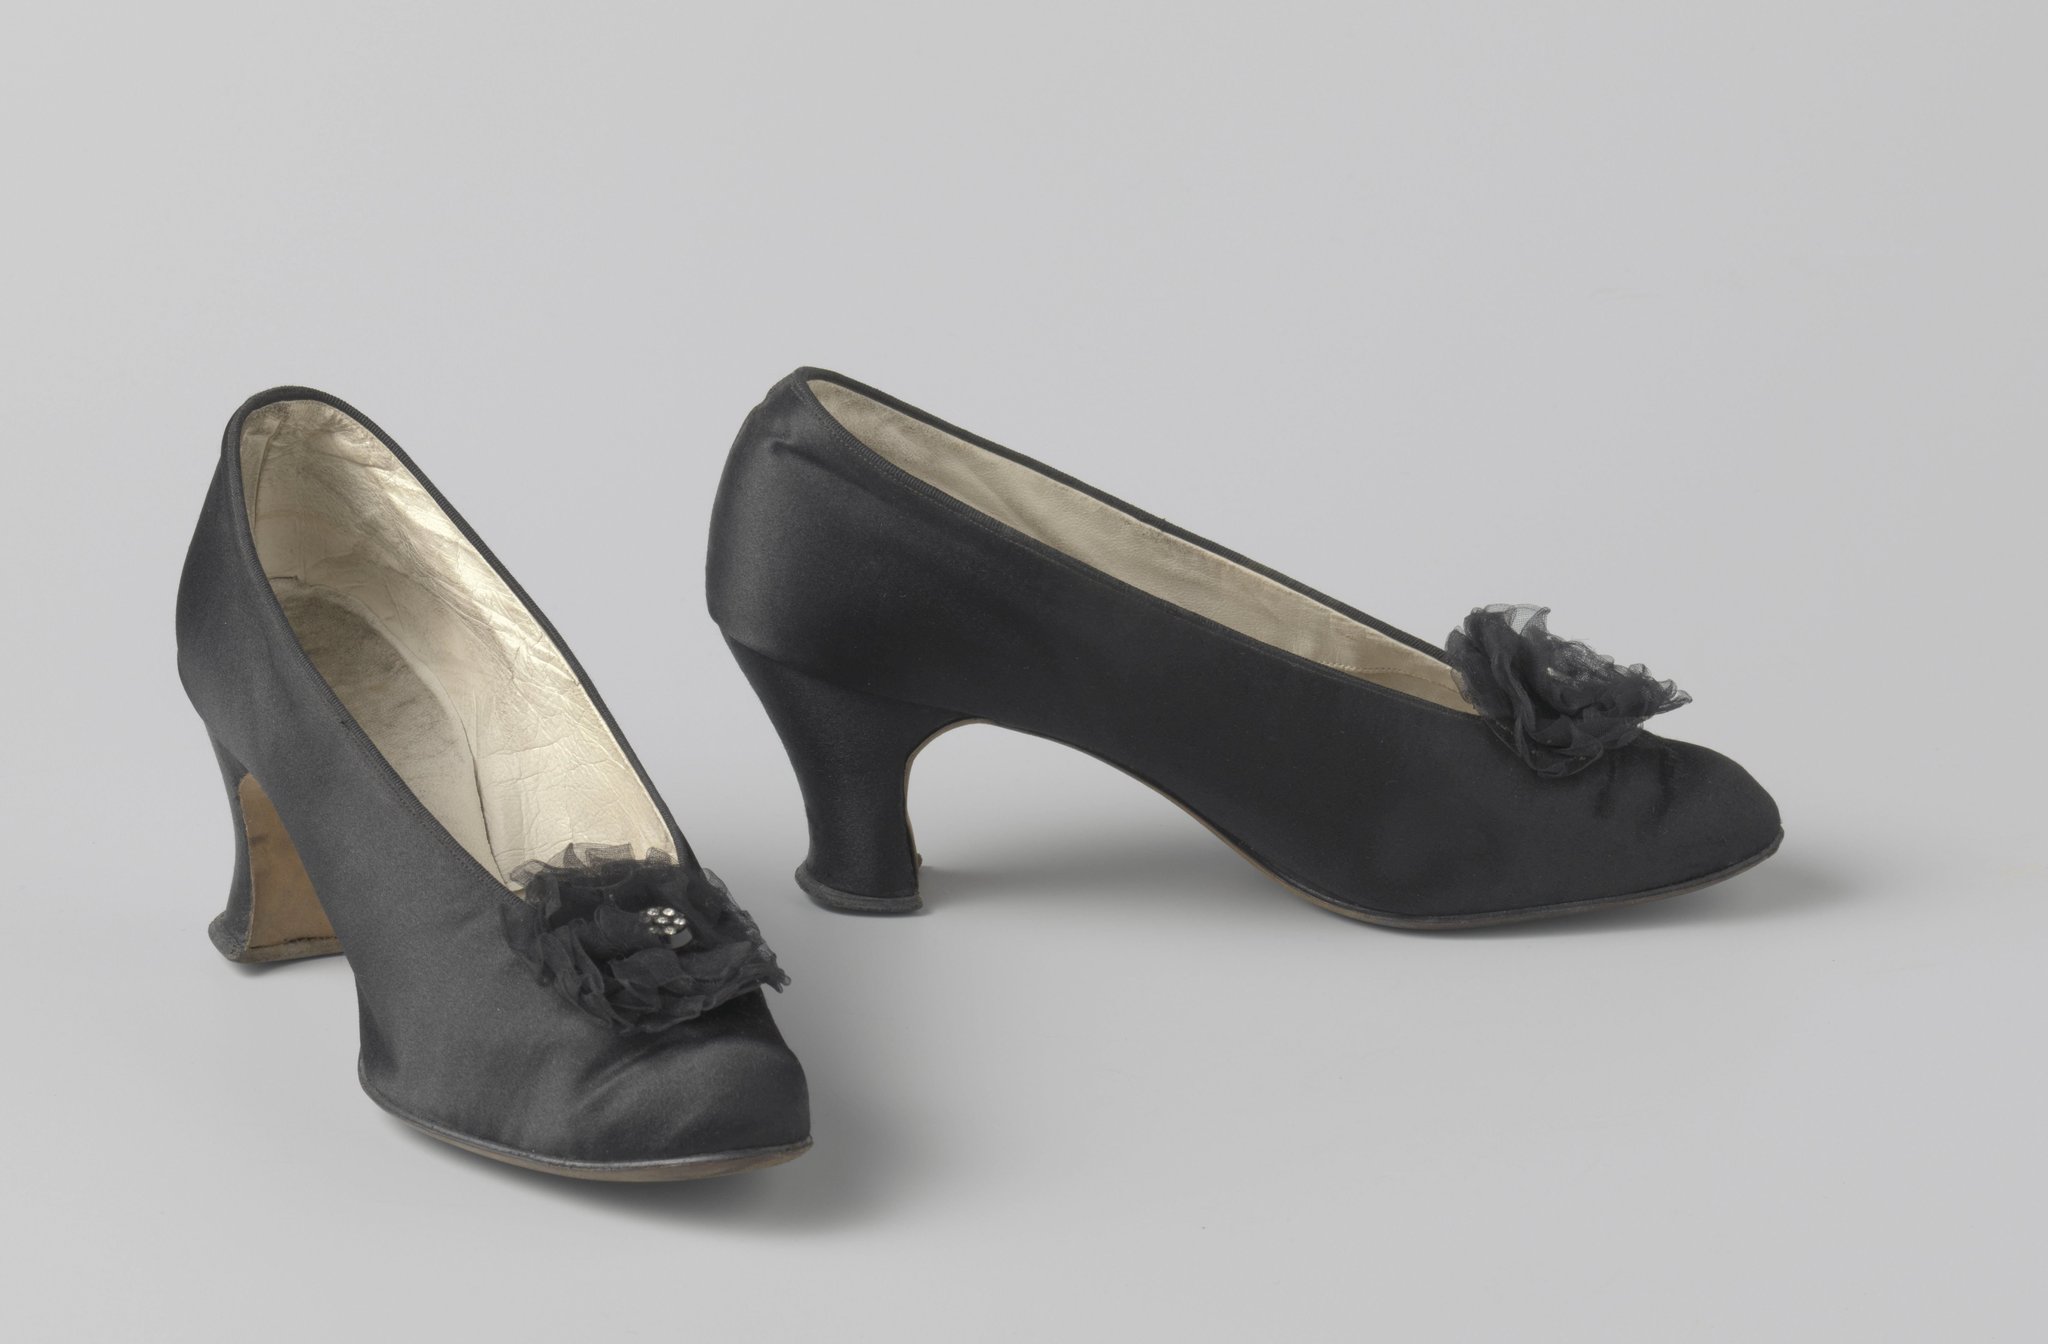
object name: shoe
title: Schoen, pump, van zwart satijn met puntneus en laag uitgesneden voorblad, versierd met pompoentjes van zwart zijden gaas met knoop met zeven namaak diamanten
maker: Anonymous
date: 1915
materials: diamond, textile, silk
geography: paris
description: Pump van zwart satijn. Puntneus. Uit één, laag uitgesneden (voor)blad. Matig hoge hak, middelzwaar, iets uitgehold. Gevoerd met wit glacéleer. Versierd met pompoentjes van zwart zijden gaas, waarop een zwart knoopje met zeven namaakdiamantjes.